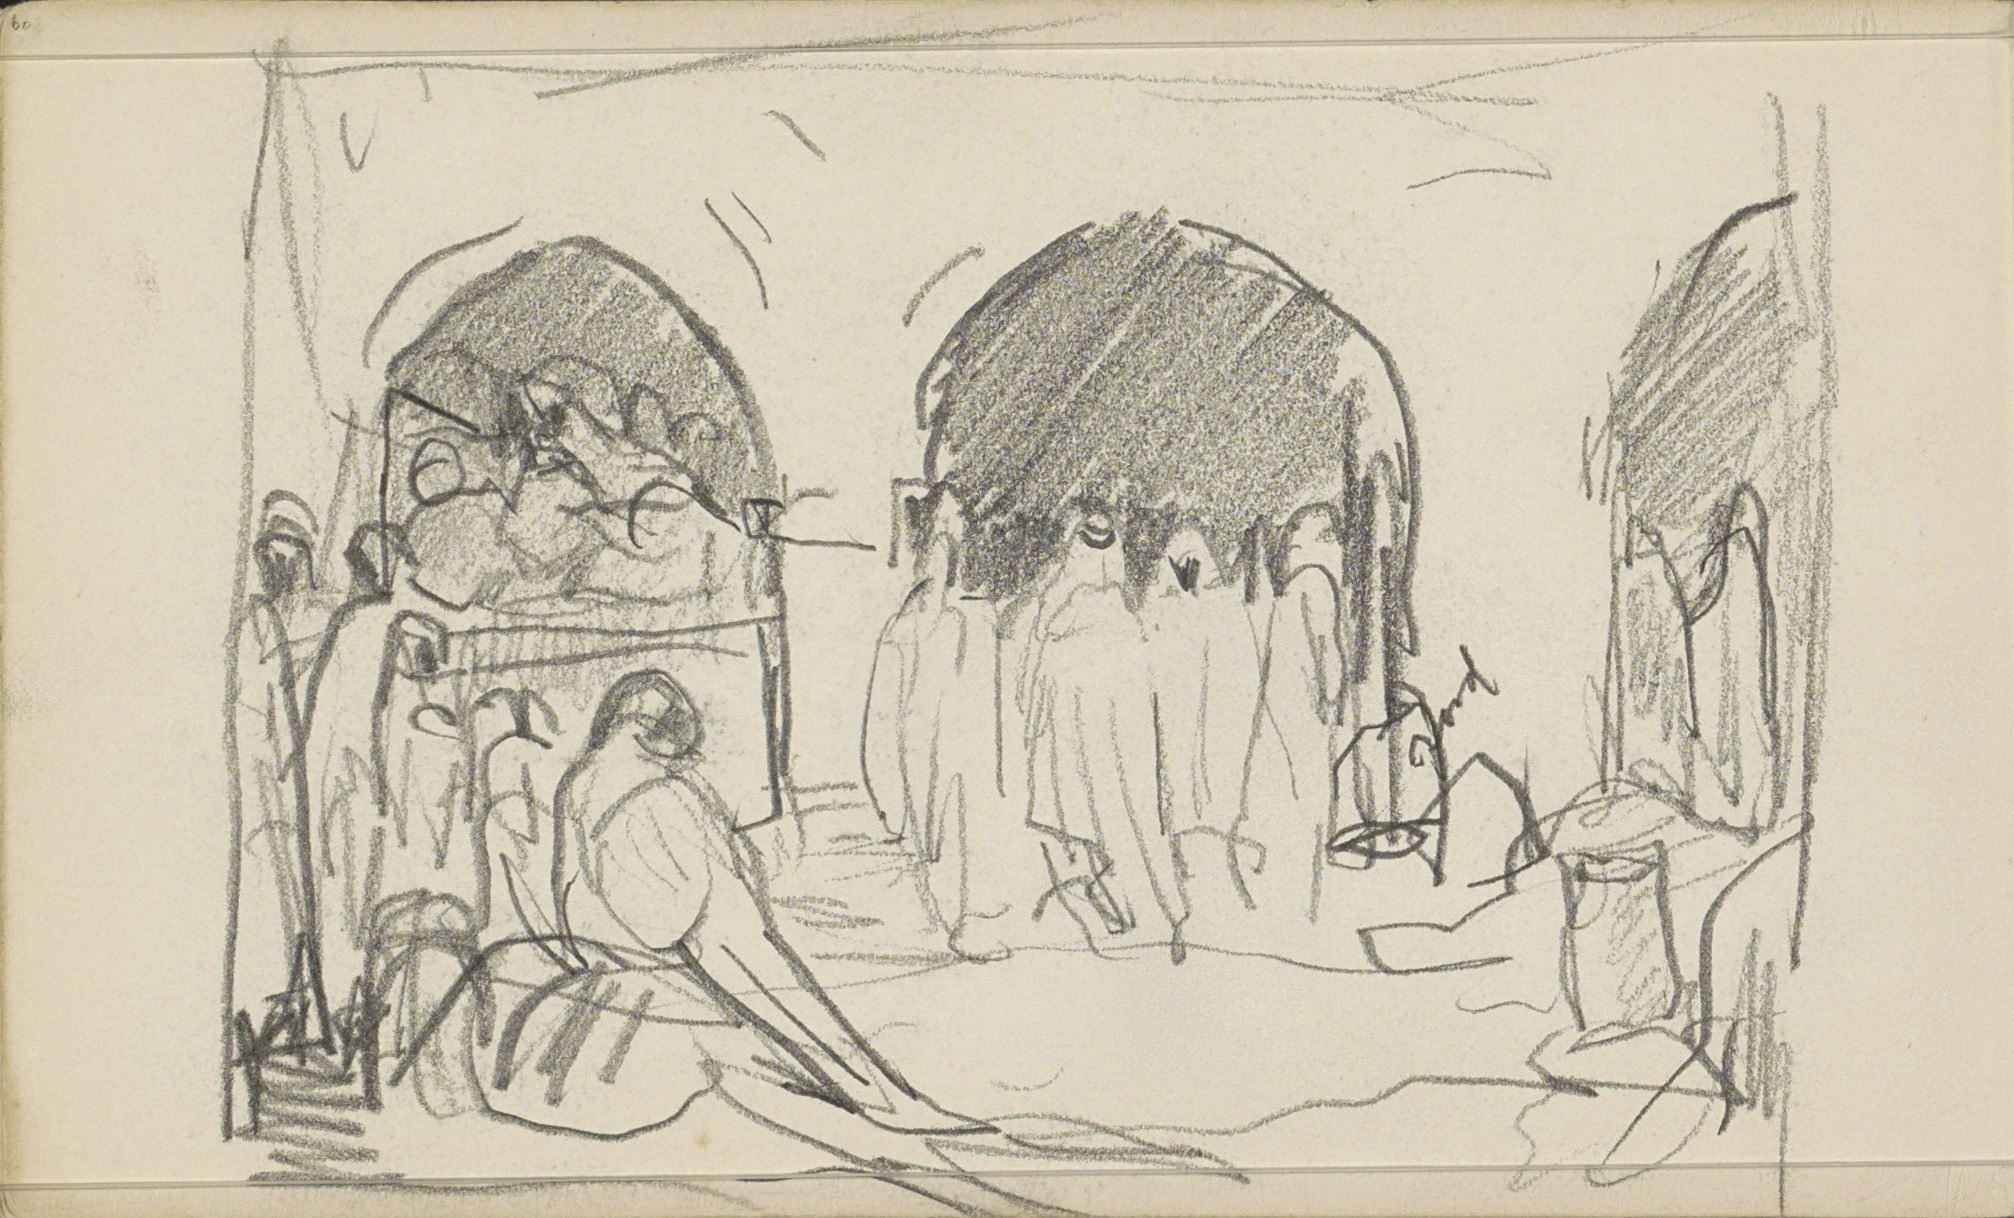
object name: sketchbook leaf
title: Straat in Biskra met Algerijnen voor een gebouw met arcaden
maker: marius bauer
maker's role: draughtsman, print maker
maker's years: 1867-1932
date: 1922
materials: paper, pencil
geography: biskra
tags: africans, arcade ~ architecture, street (+ city(-scape) with figures, staffage)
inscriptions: kleurnotitie, handgeschreven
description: Pagina 60 uit een schetsboek met 31 bladen.